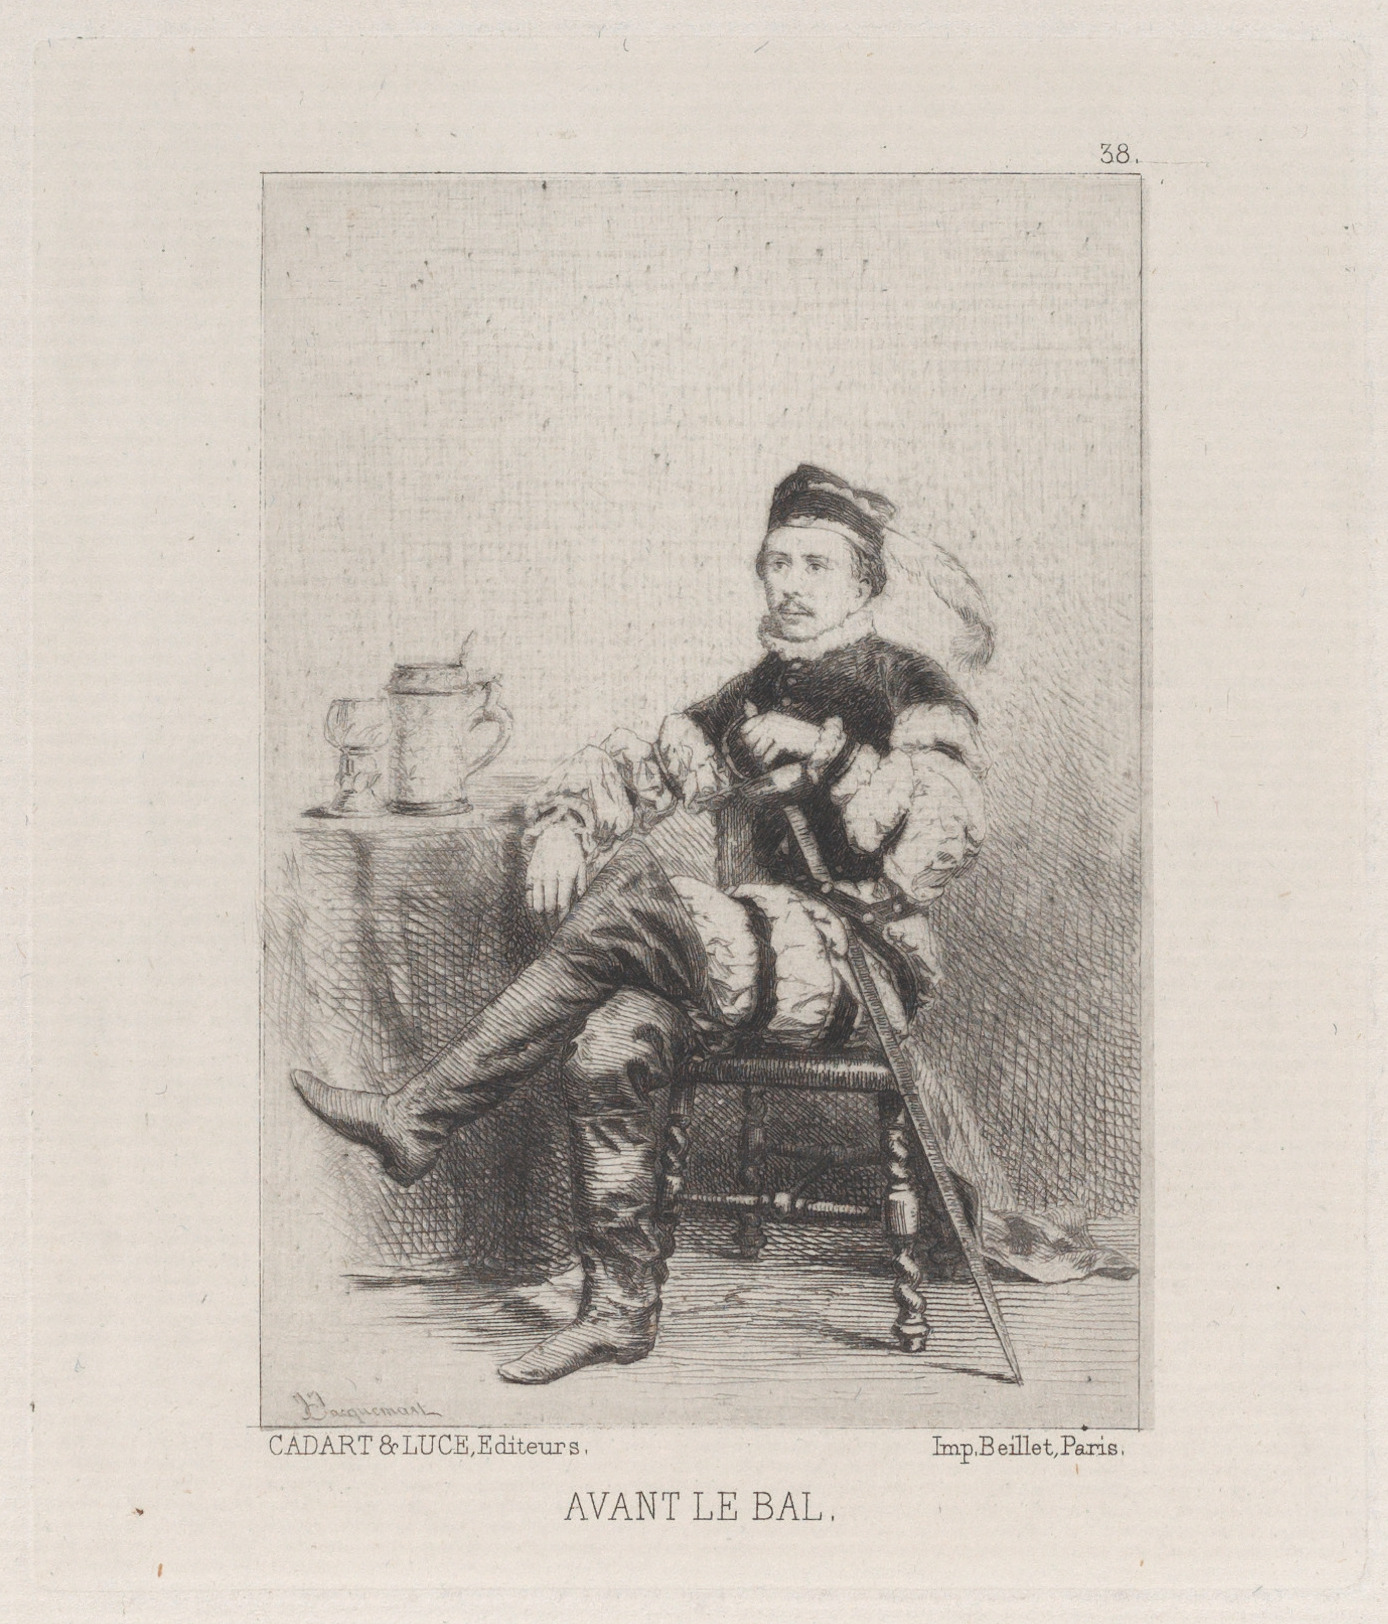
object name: print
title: Before the Ball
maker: jules-ferdinand jacquemart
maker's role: artist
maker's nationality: french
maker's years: 1837-1880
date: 1867-1871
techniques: etching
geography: paris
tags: swords,men